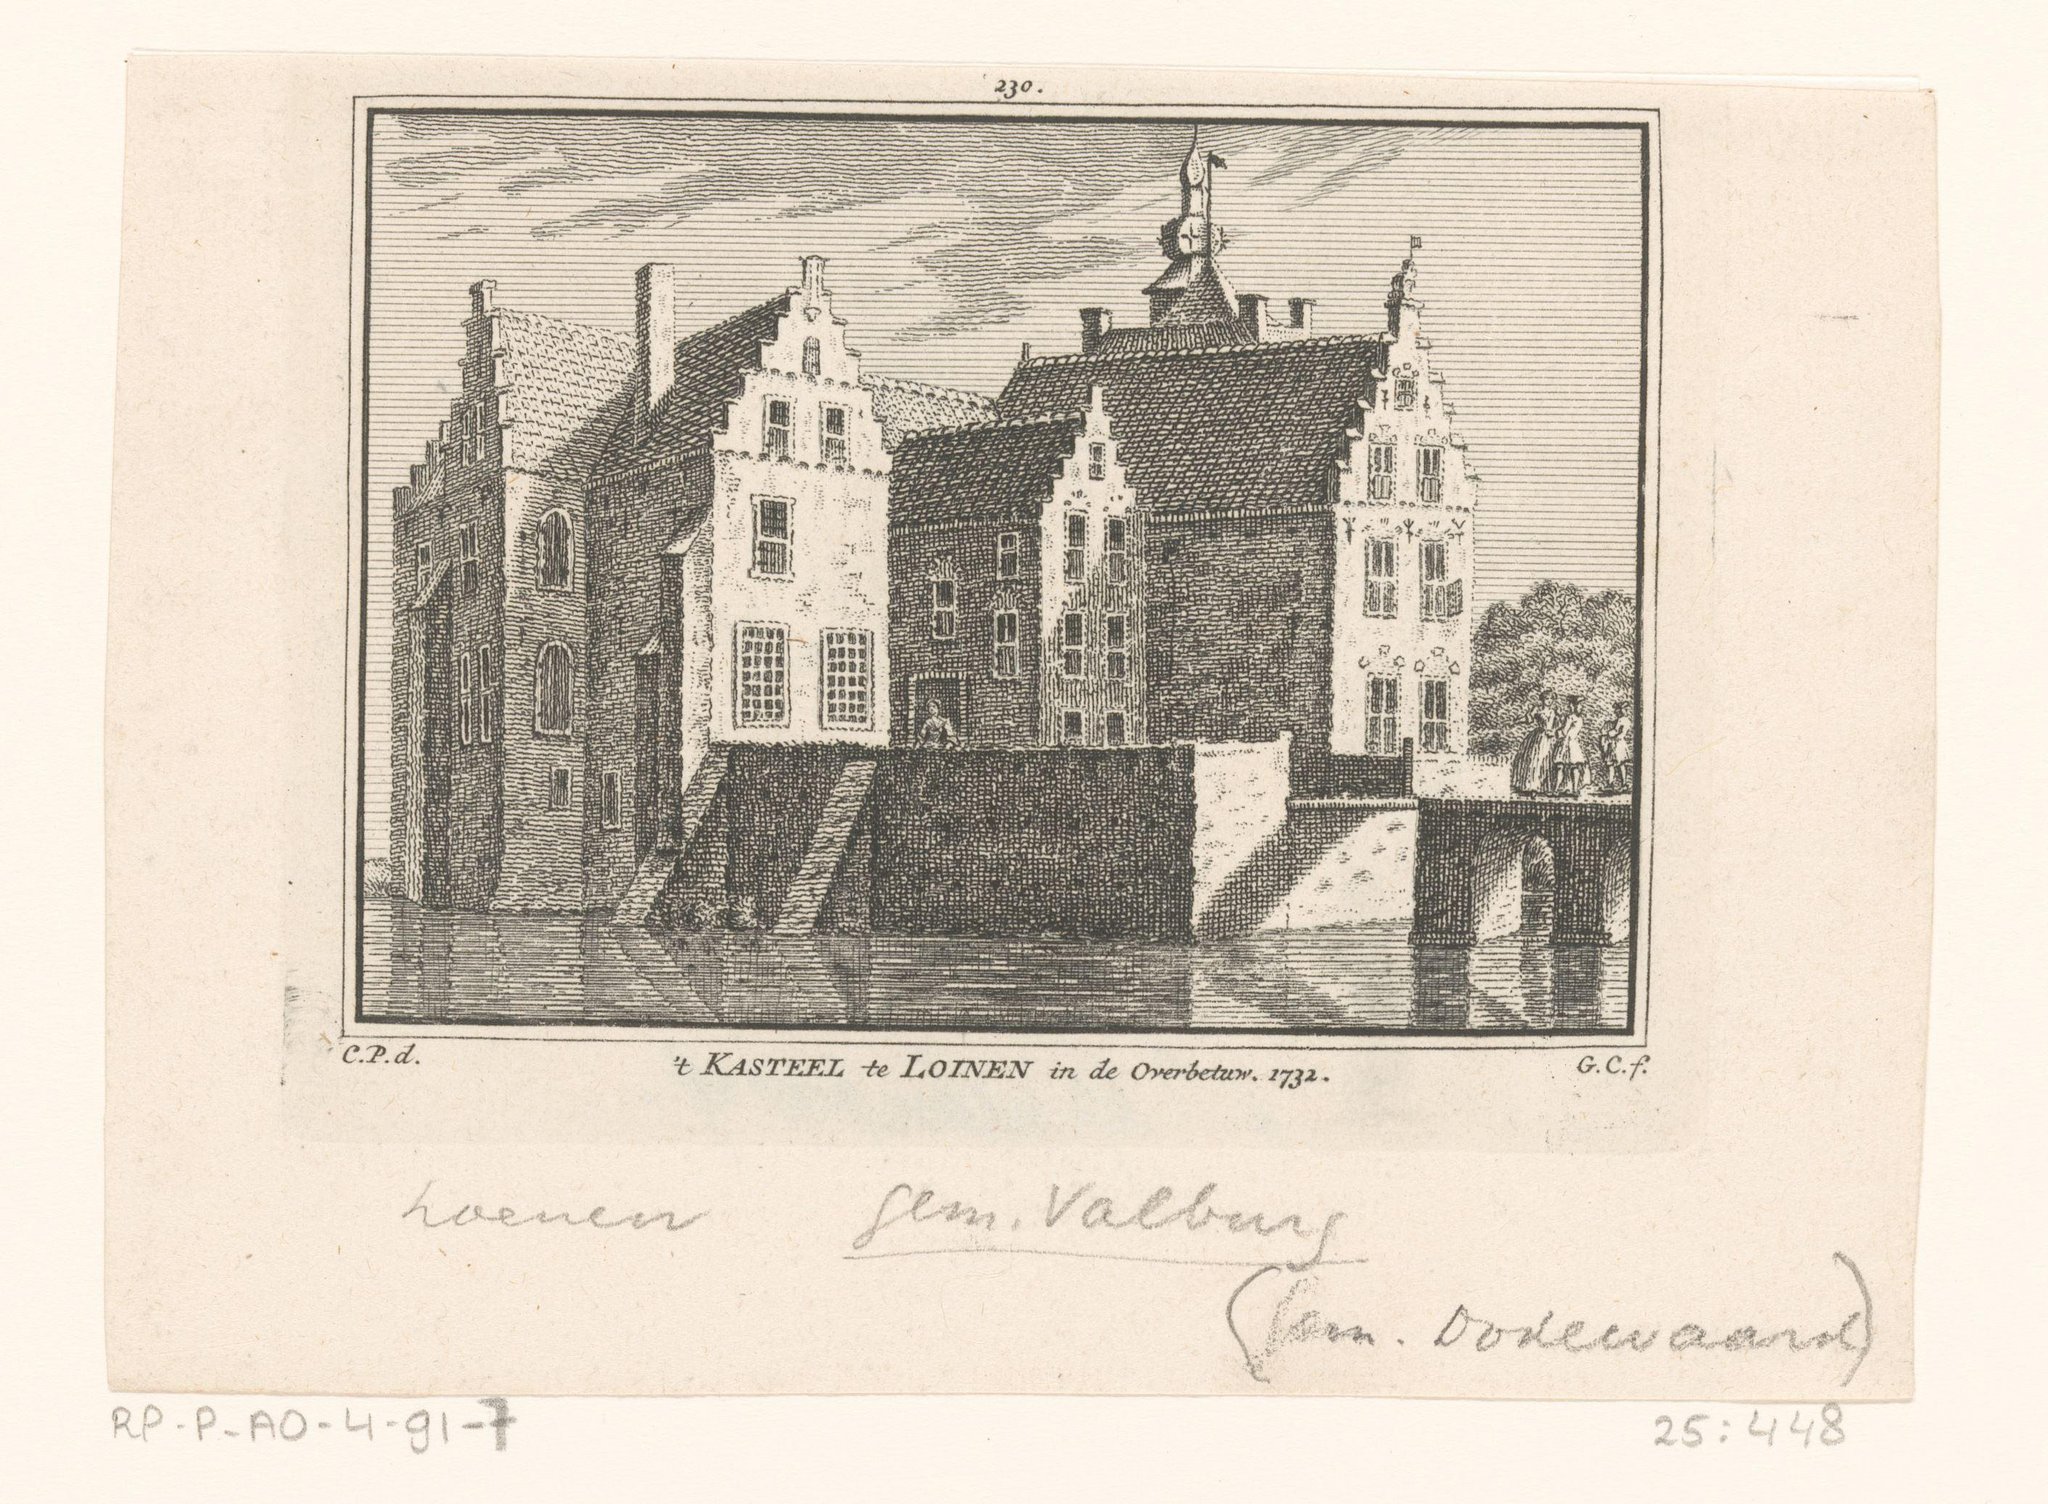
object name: print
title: Gezicht op Huis te Loenen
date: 1750-1792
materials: paper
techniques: etching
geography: amsterdam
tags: castle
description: Prent ook gebruikt in: Het verheerlykt Nederland of kabinet van hedendaagsche gezigten van steden, dorpen (…). 9 delen. Amsterdam: Isaak Tirion en weduwe Isaak Tirion, 1745-1774, dl. 3 (1750), ill. 230. Of in: Nederlandsche tafereelen; of eene keurige verzameling van negen honderd fraaije gezigten van steden, dorpen, sloten, oudheden (….). 9 delen. Amsterdam: Jan de Groot, 1792, dl. 3, ill. 230.